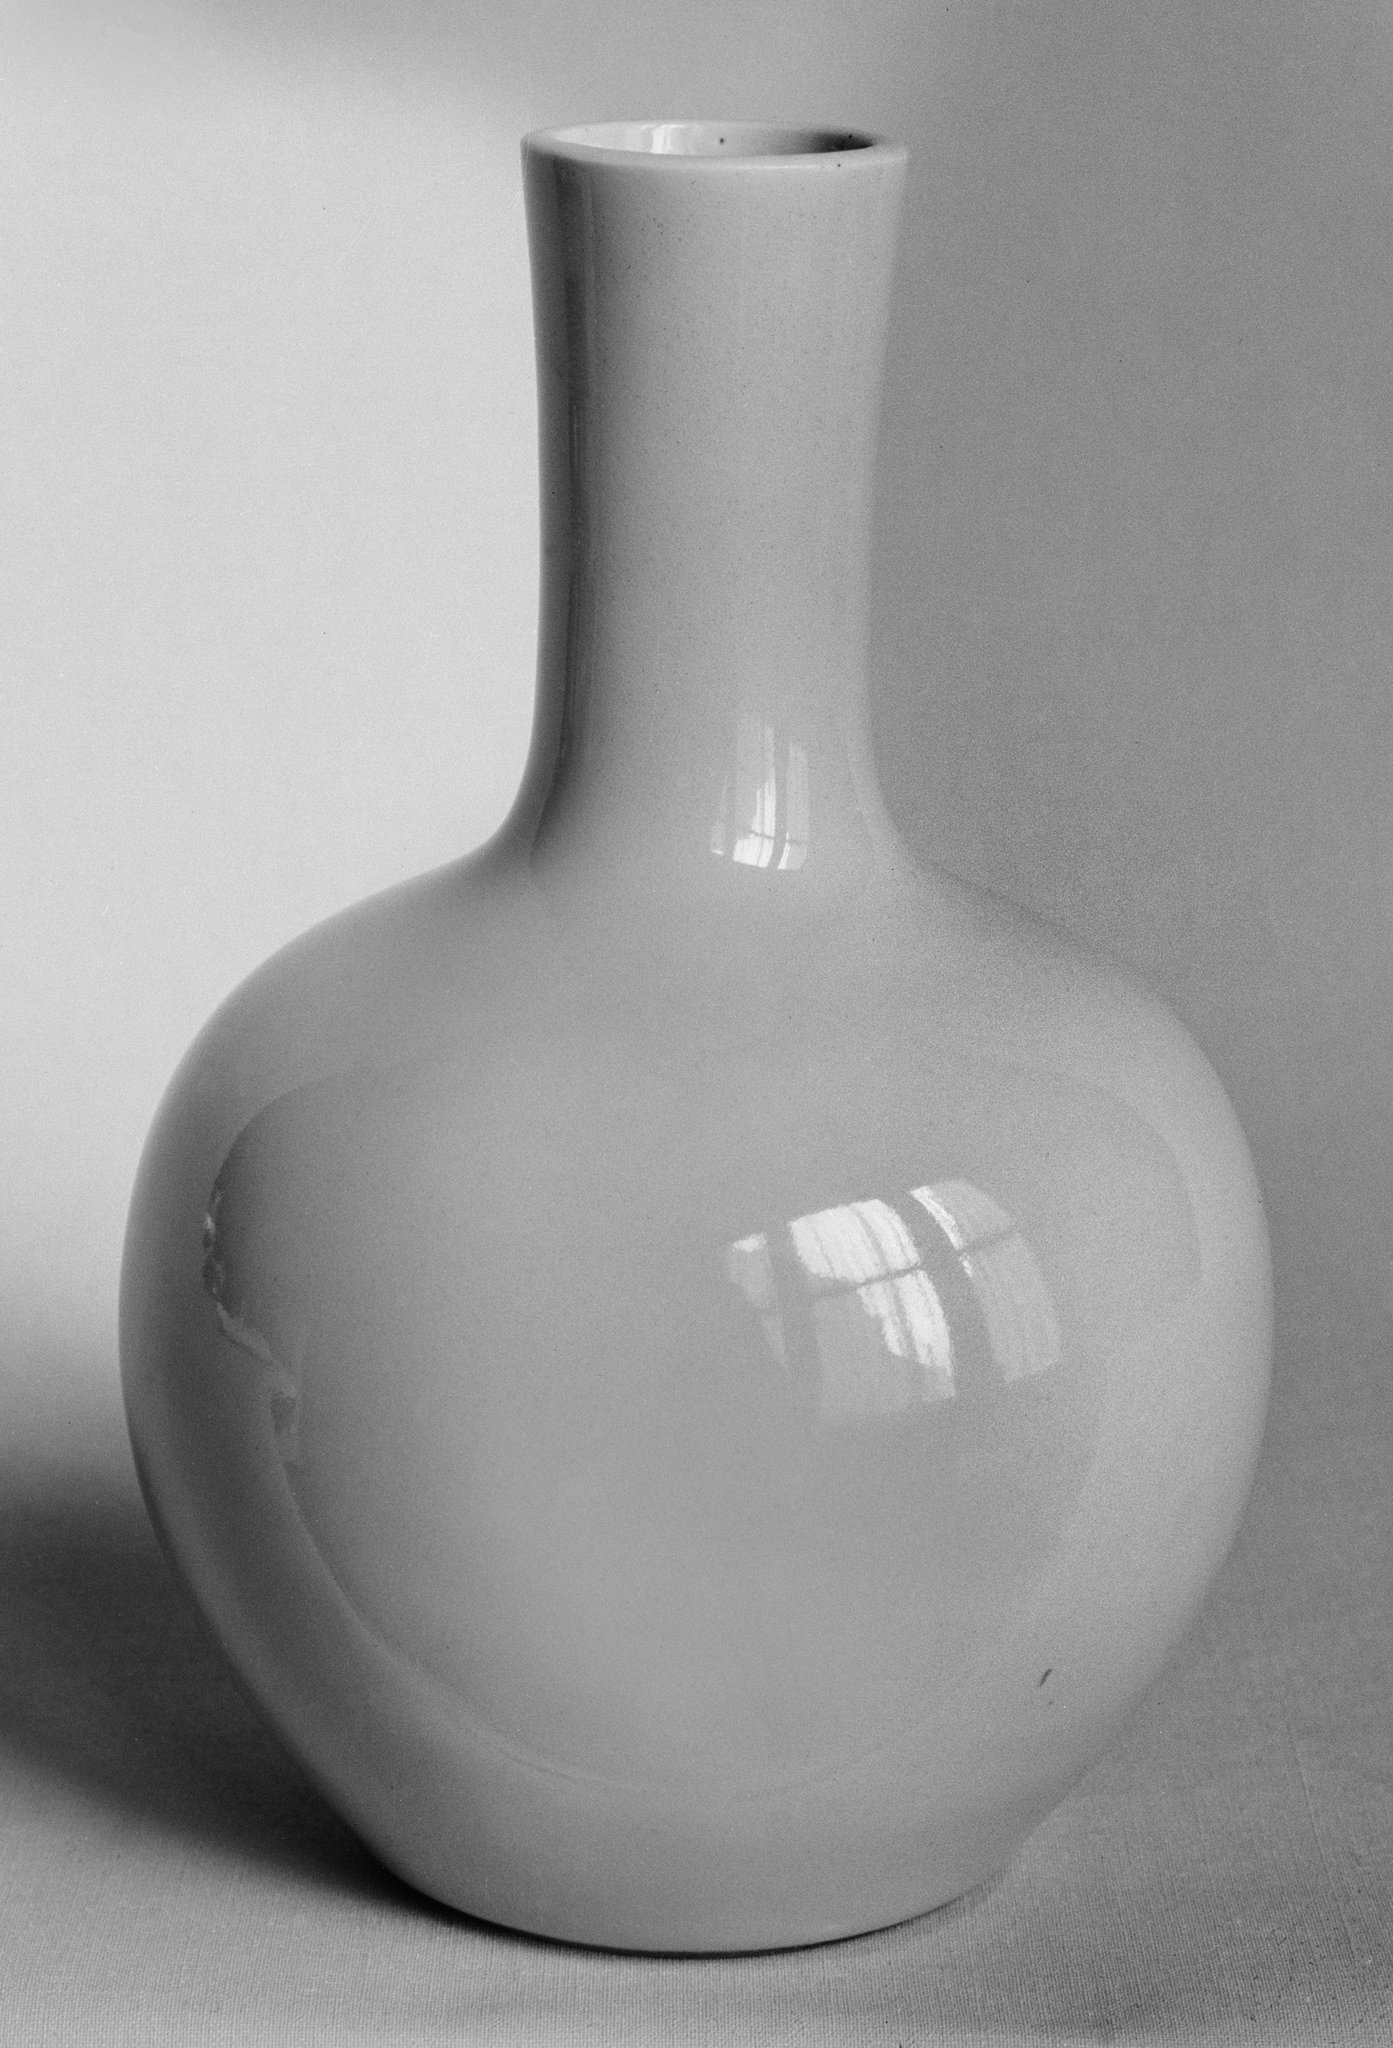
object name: bottle vase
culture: chinese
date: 1701-1800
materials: glaze, porcelain